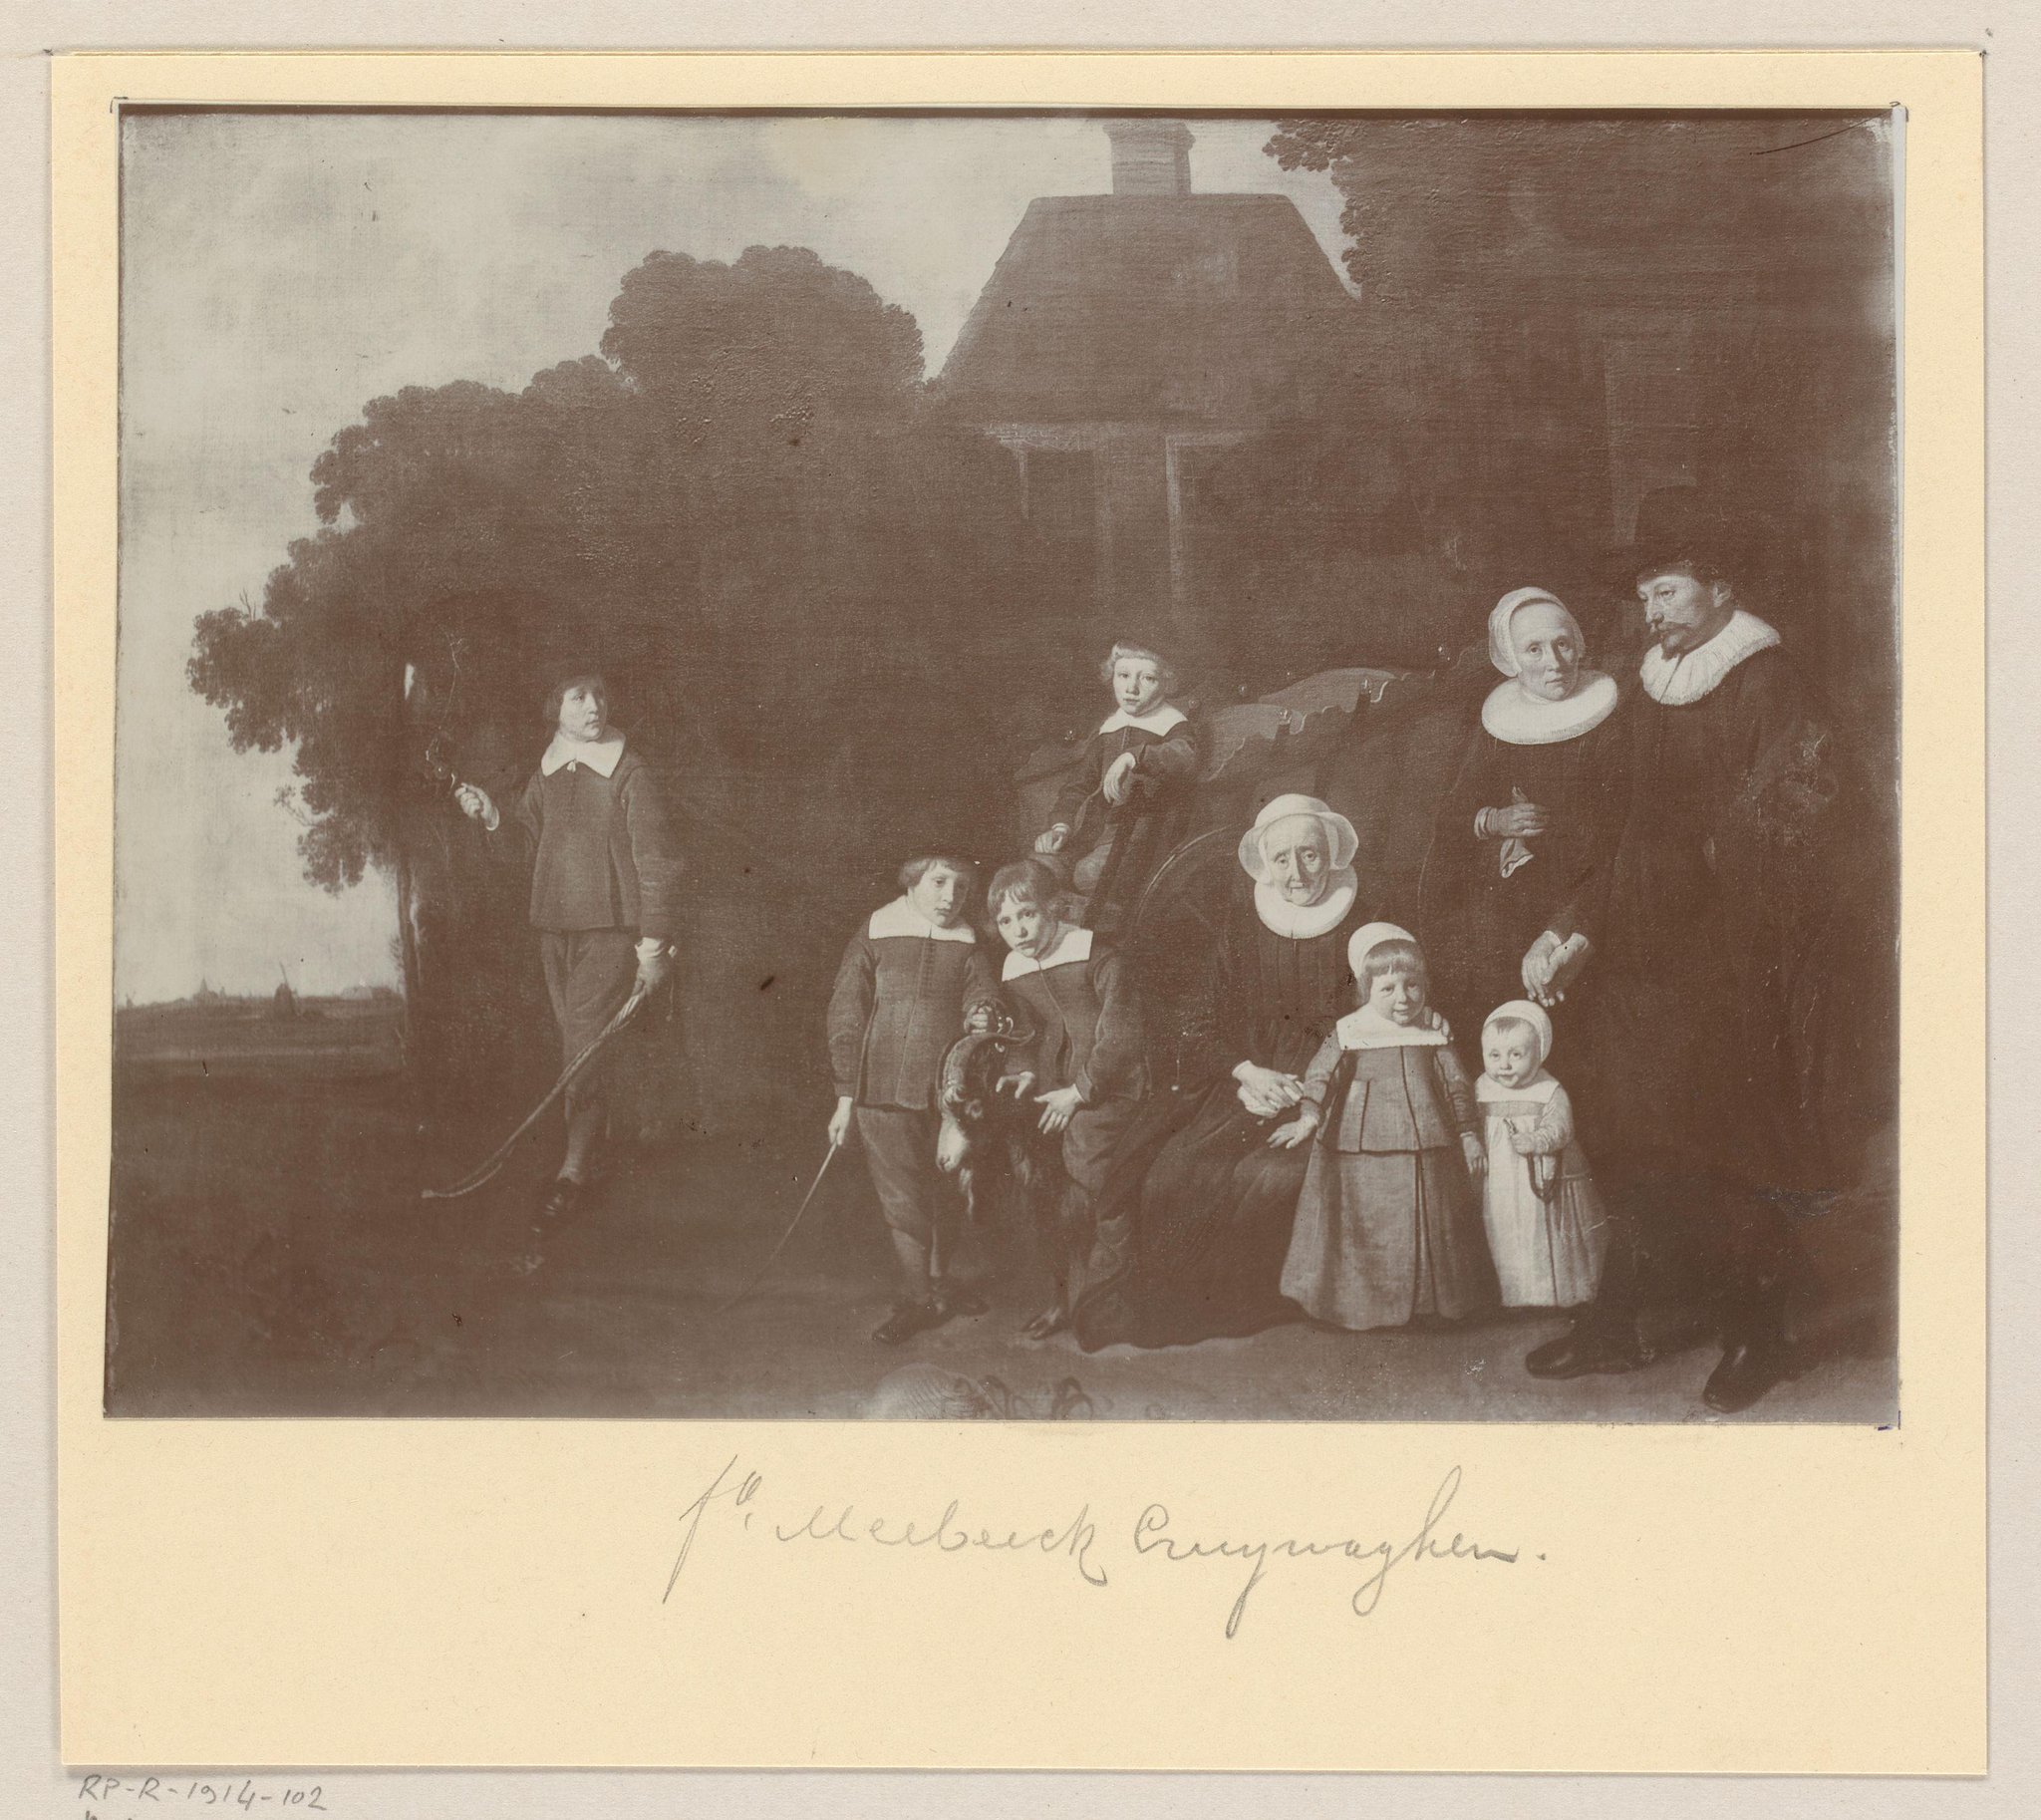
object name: reproduction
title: Fa. Meebeeck Cruywaghen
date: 1880-1910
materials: paper, cardboard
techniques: collodion silver print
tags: family life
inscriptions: collector's mark: Lugt 2228